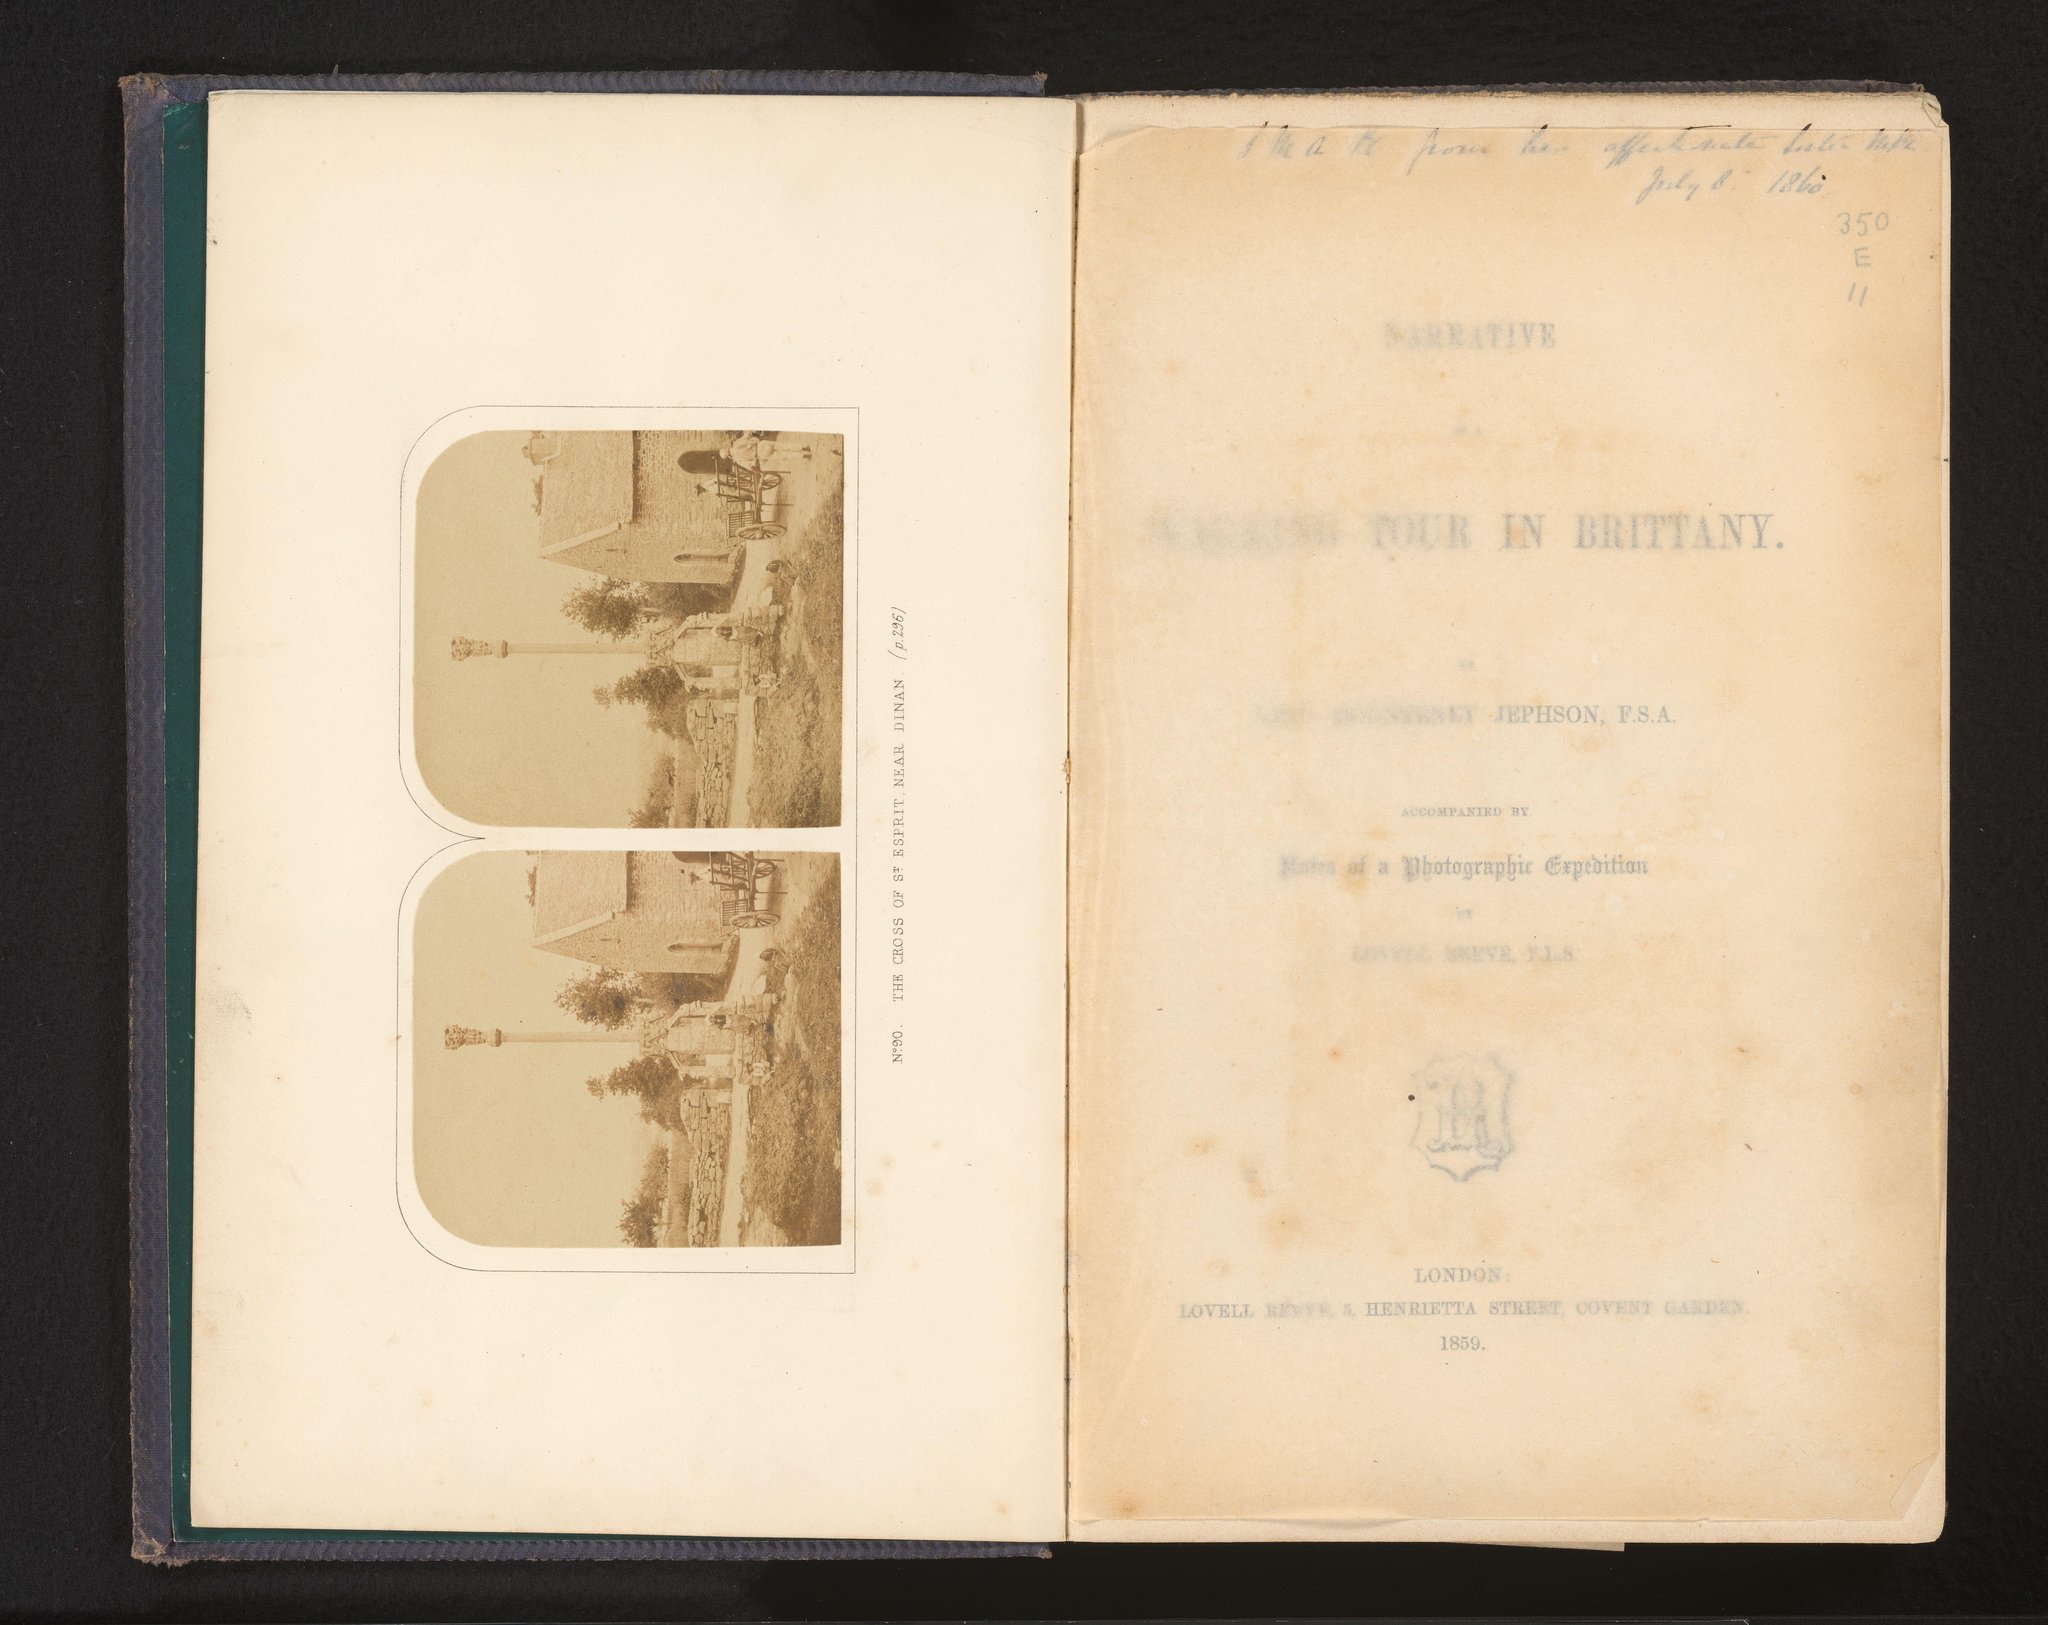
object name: stereograph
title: The Cross of St. Esprit near Dinan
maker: lovell augustus reeve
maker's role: publisher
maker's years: 1814-1865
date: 1854-1859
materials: paper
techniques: albumen print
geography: dinan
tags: the cross ~ symbols of christ, monument, statue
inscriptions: inscription: ‘(p. 296)’, number: ‘No. 90.’